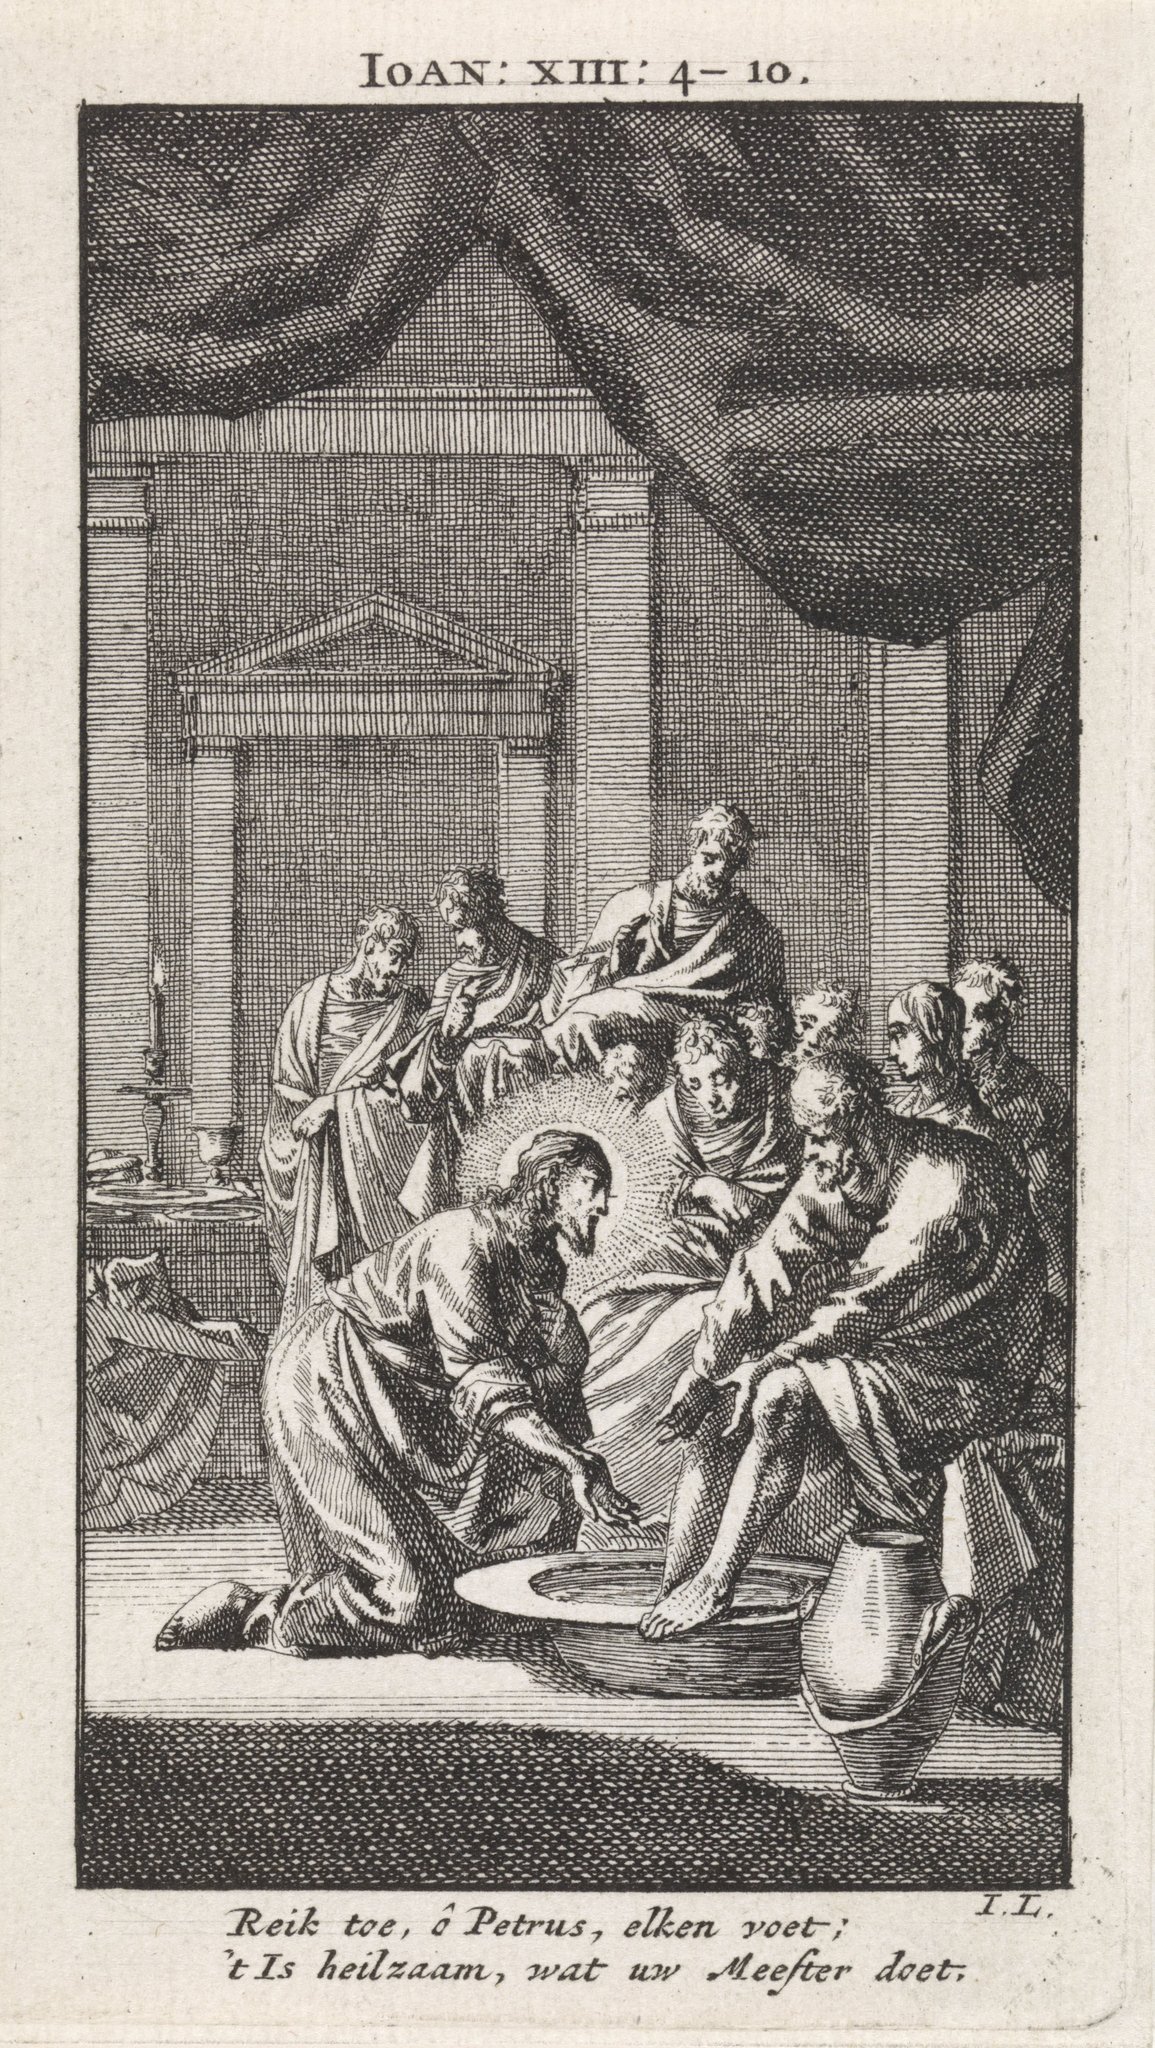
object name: print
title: Voetwassing van Petrus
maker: jan luyken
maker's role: draughtsman, print maker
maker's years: 1649-1712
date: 1712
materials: paper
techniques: etching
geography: amsterdam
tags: christ washes peter's feet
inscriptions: collector's mark: Lugt 2228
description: Illustratie voor: Luyken, Jan. Bybel printen. Amsterdam: Pieter Arentsz. II (wed.) en Cornelis van der Sys, 1712, p. 33.